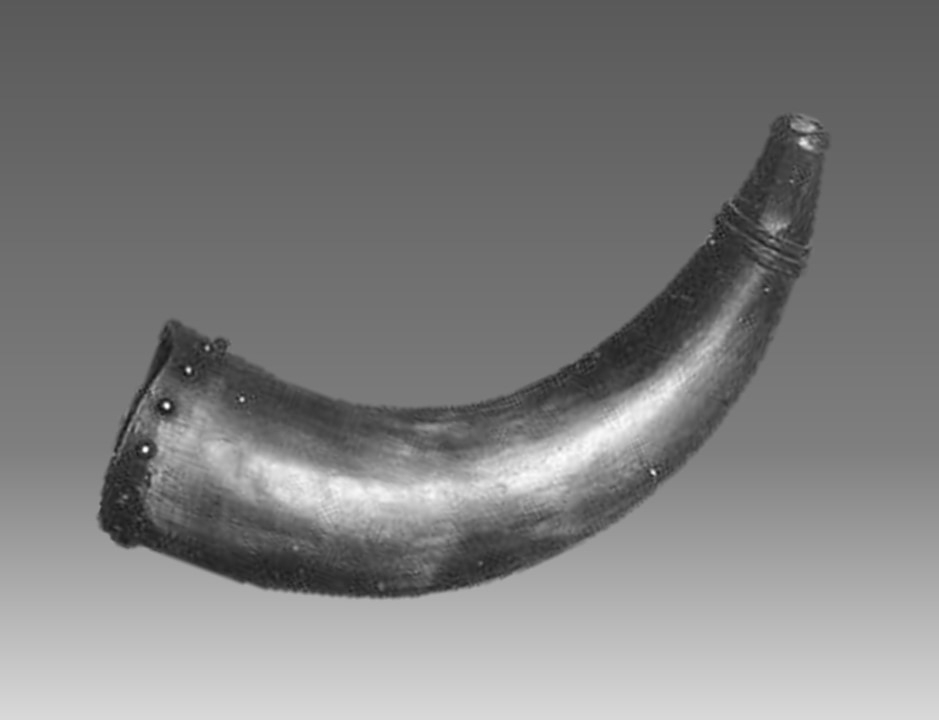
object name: rattle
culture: native american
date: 1801-1900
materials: textile, horn, metal, wood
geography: united states